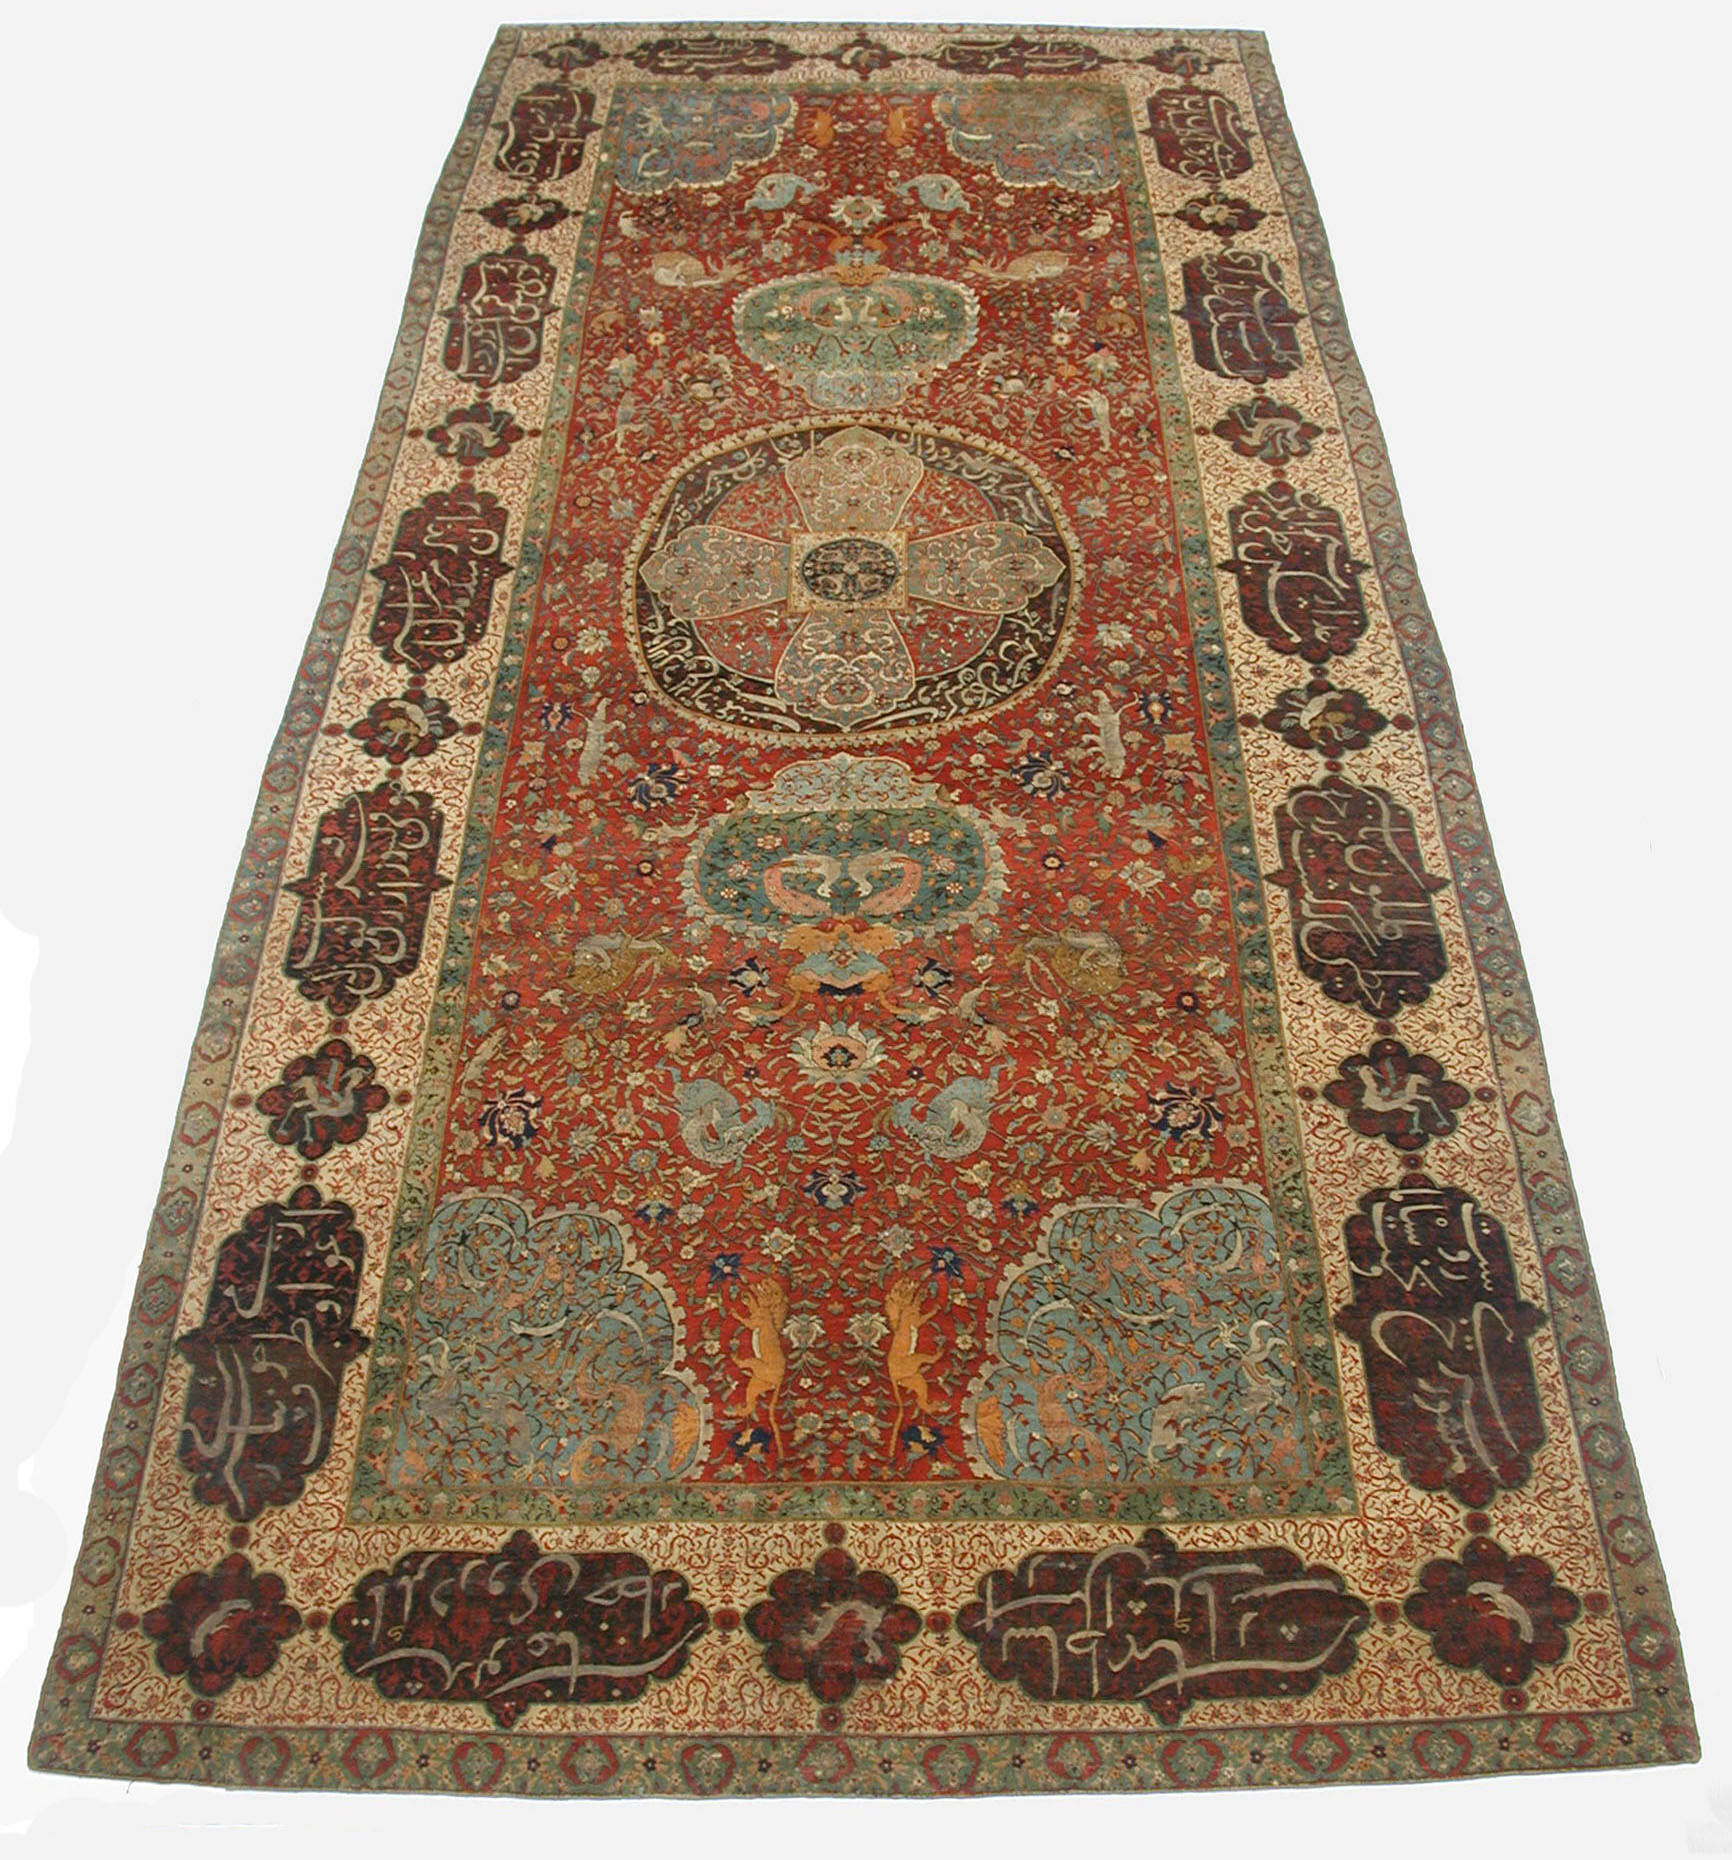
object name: carpet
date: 1501-1600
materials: metal thread, silk, wool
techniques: brocade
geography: iran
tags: animals,peacocks